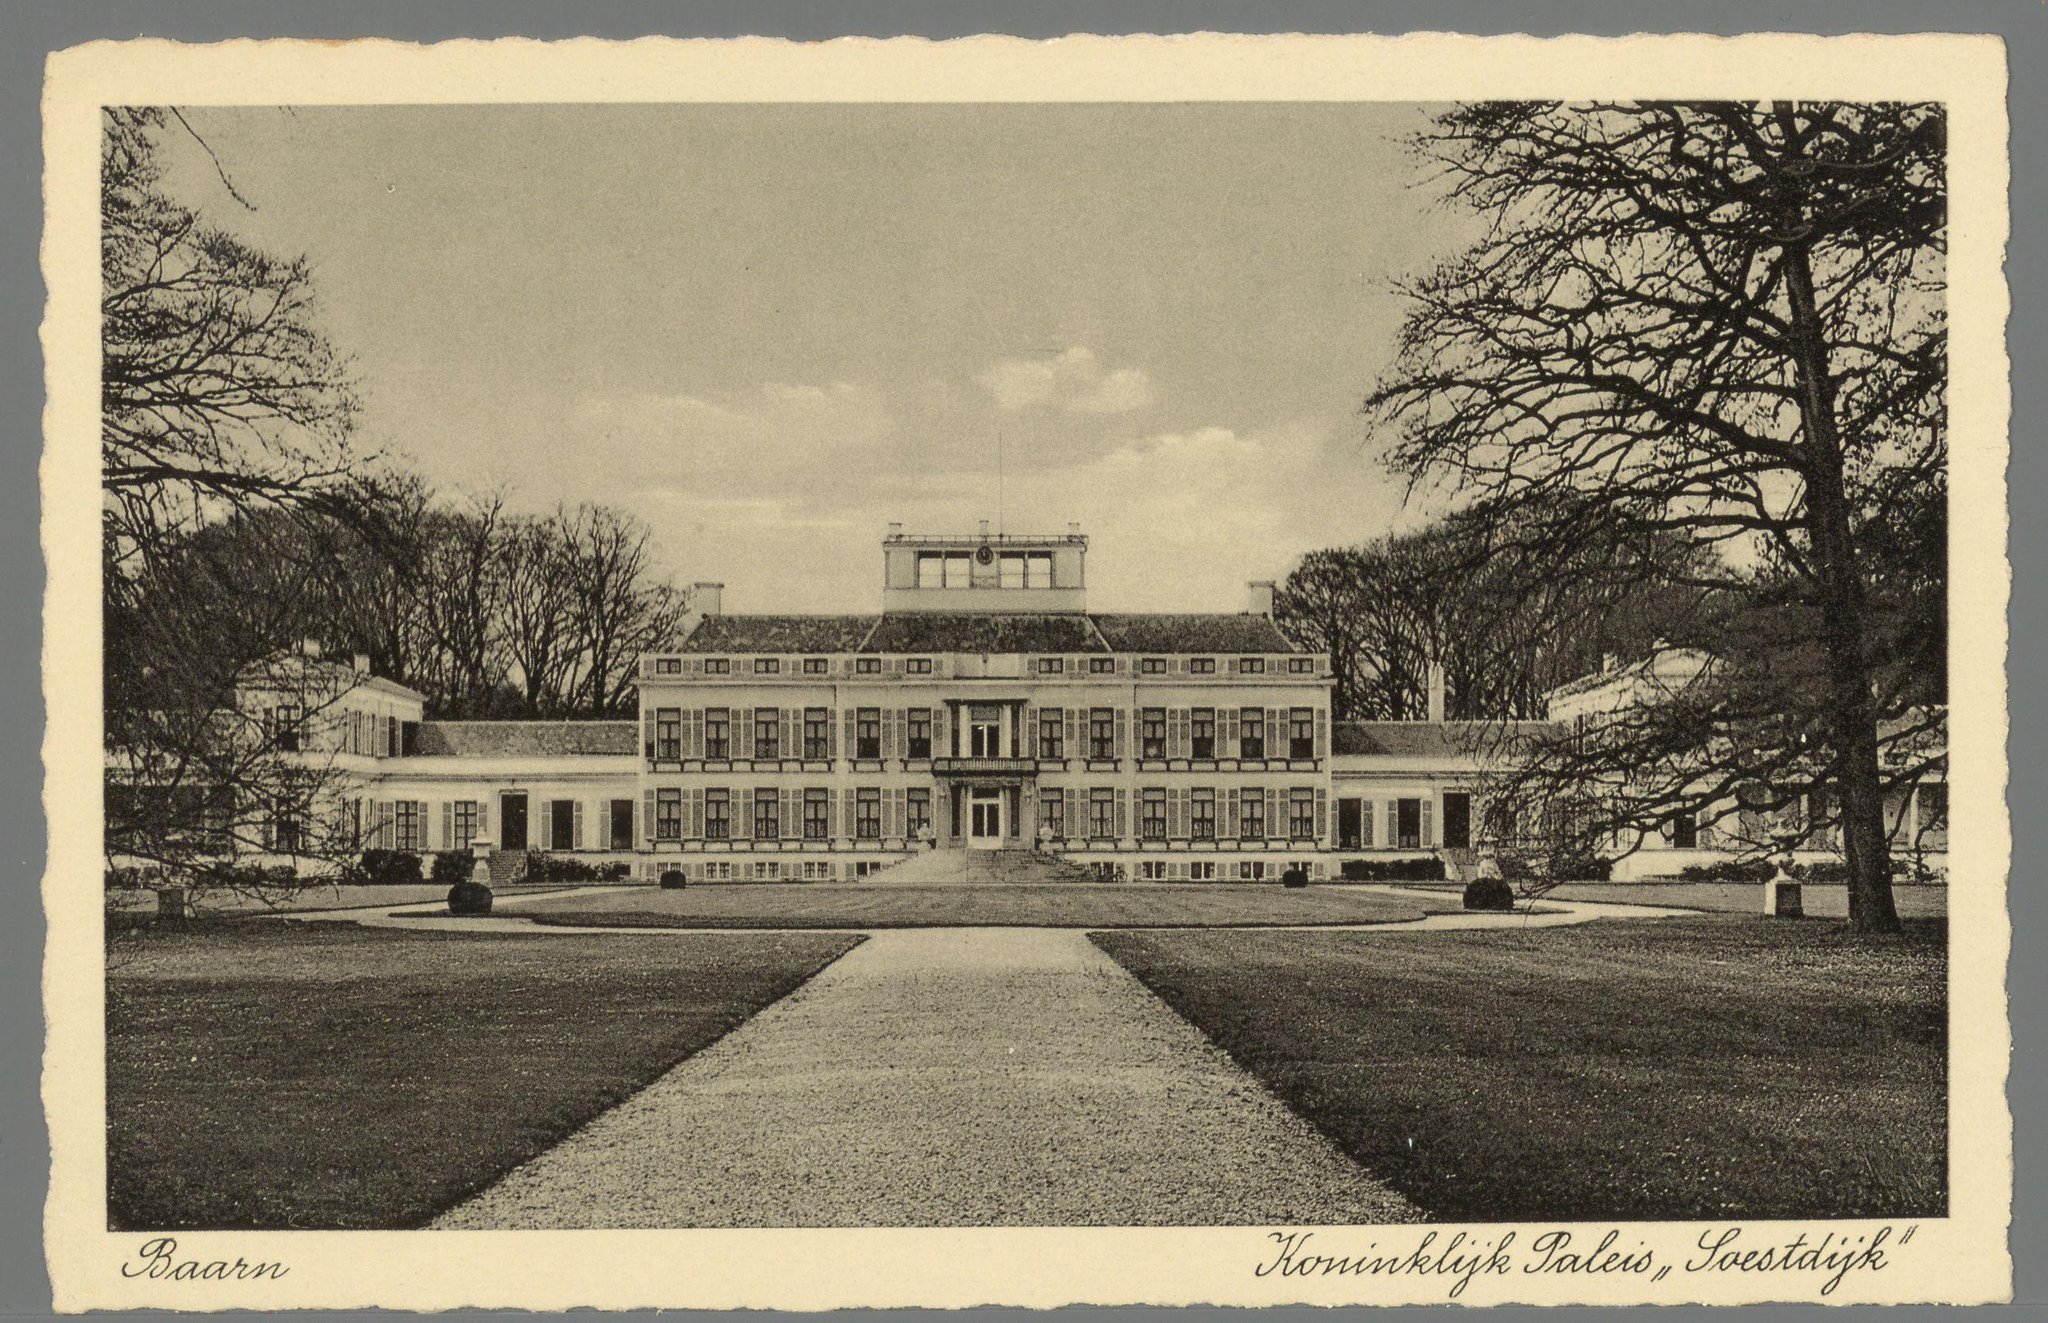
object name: ansichtkaart, prentbriefkaart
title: Baarn. Koninklijk Paleis "Soestdijk"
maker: Anonymous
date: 1913-1950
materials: cardboard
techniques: photograph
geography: baarn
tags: palace